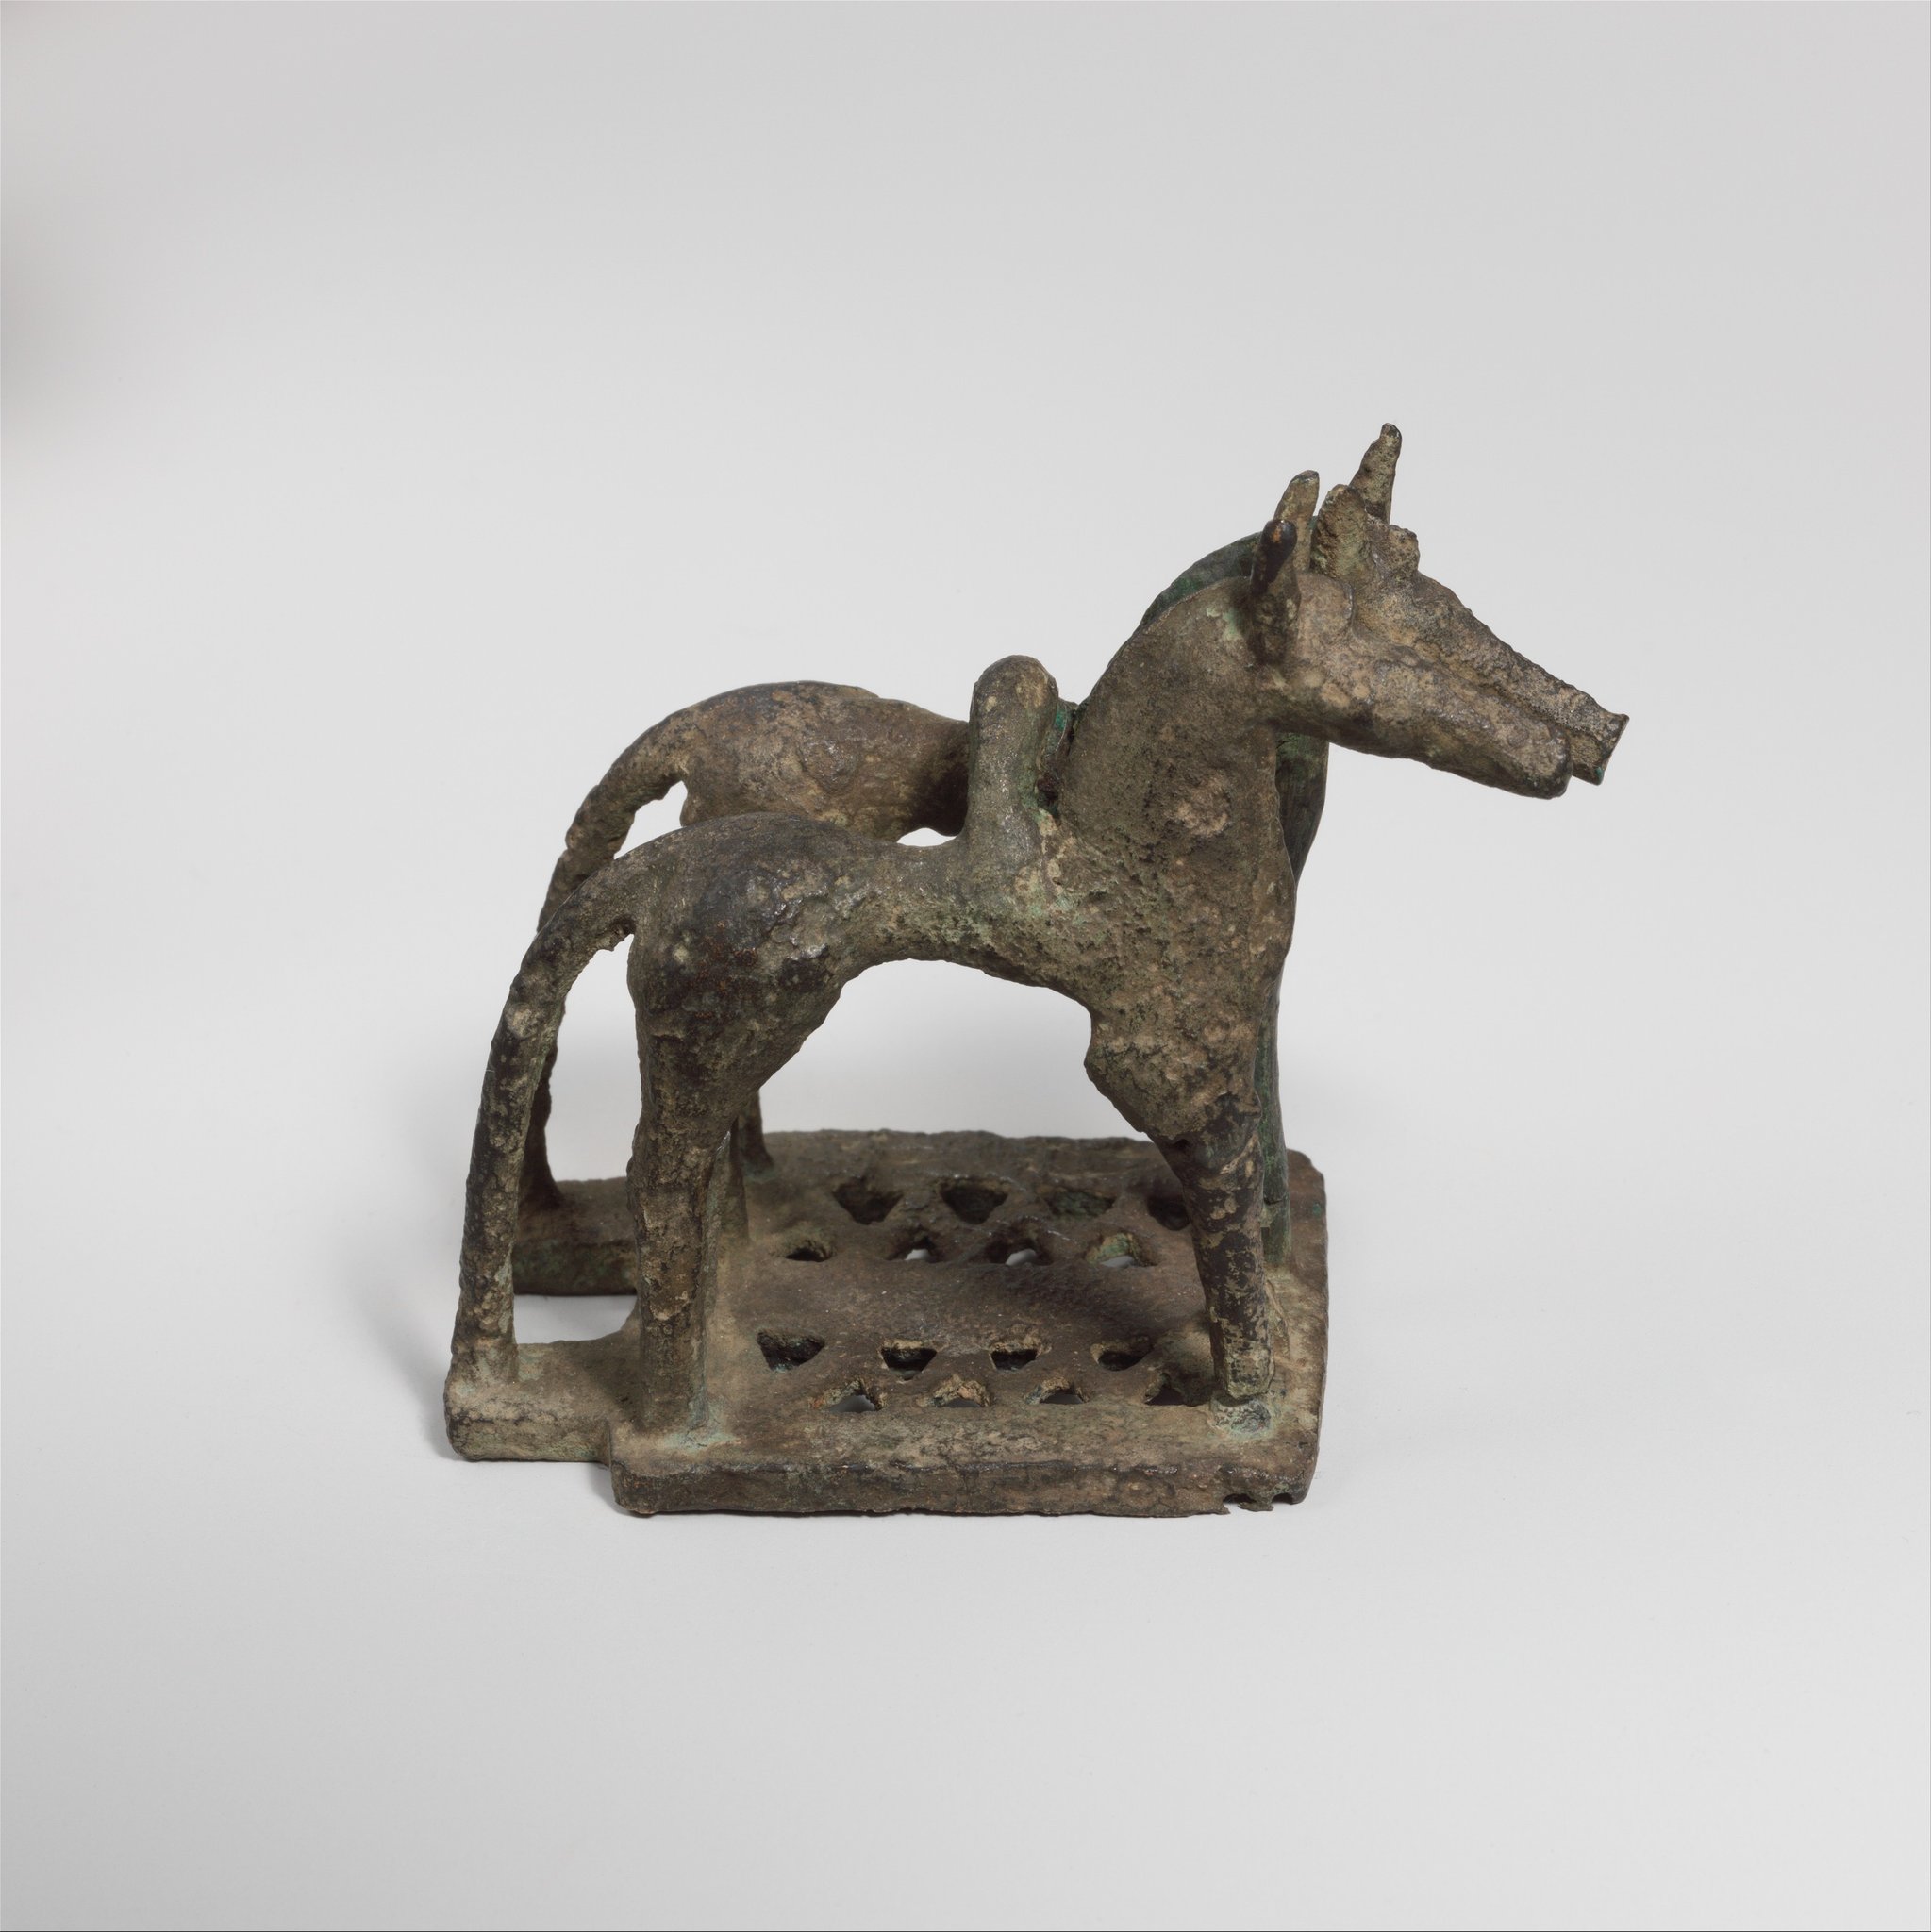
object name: statuette of a horse team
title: Bronze statuette of a team of horses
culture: greek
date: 800-701 BCE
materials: bronze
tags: horses